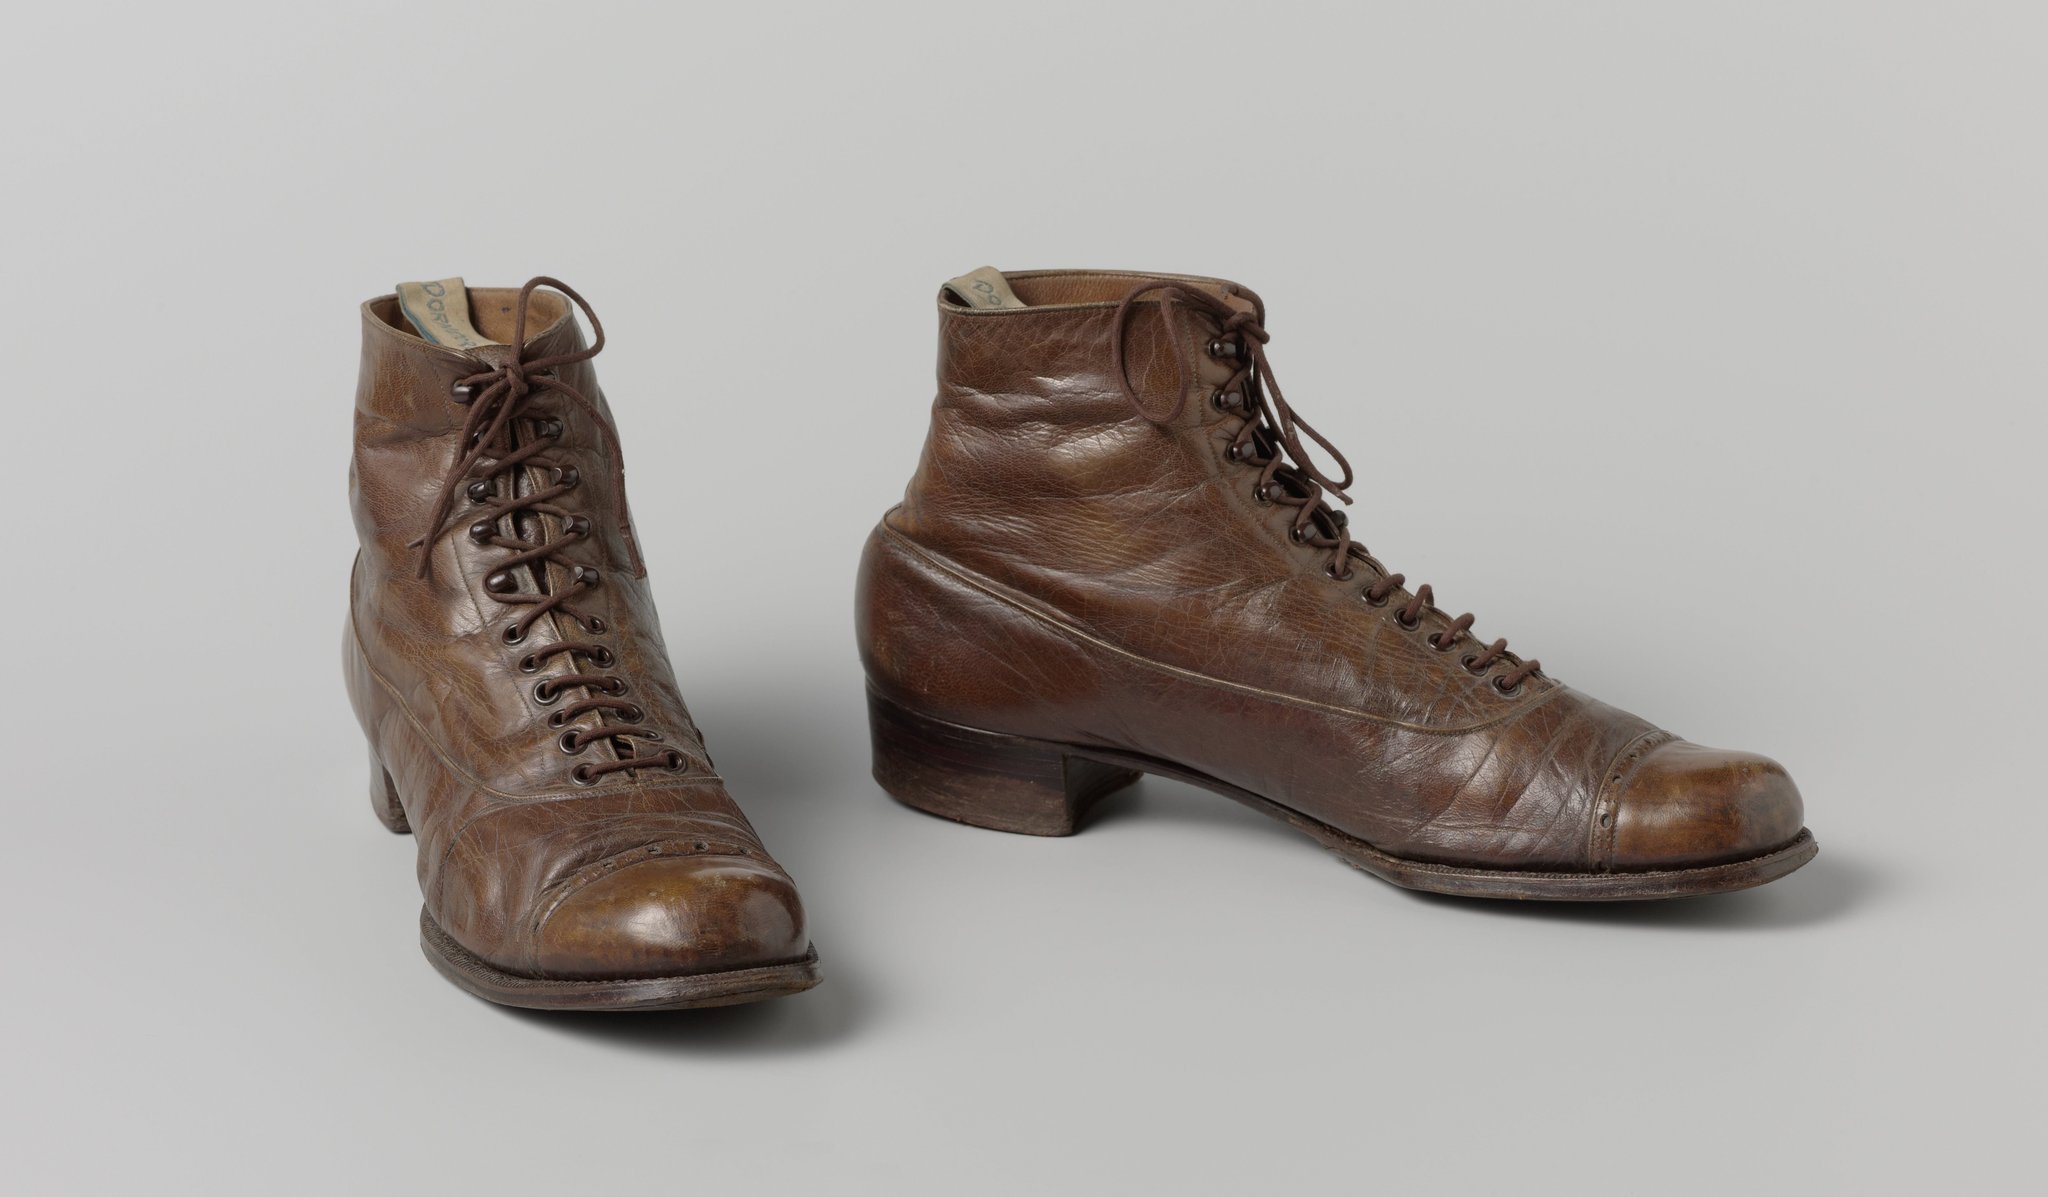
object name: clothing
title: Laars van lichtbruin kalfsleer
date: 1925-1935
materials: leather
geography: niederauerbach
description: Linkerlaars van lichtbruin kalfsleer. Model: schat uit drie delen tot even boven de enkel. Rond verstevigd neusstuk met geponste sierrand. Zoolleer is genaaid, Lage en brede hak bestaande uit laagjes leer. In het rijggedeelte de helft van open rijggatjes de andere helft van bruine weerhaakjes om de veters omheen te slingeren. Bovenaan van achter een aantreklus. Adres (op de lus): Dorndorf.